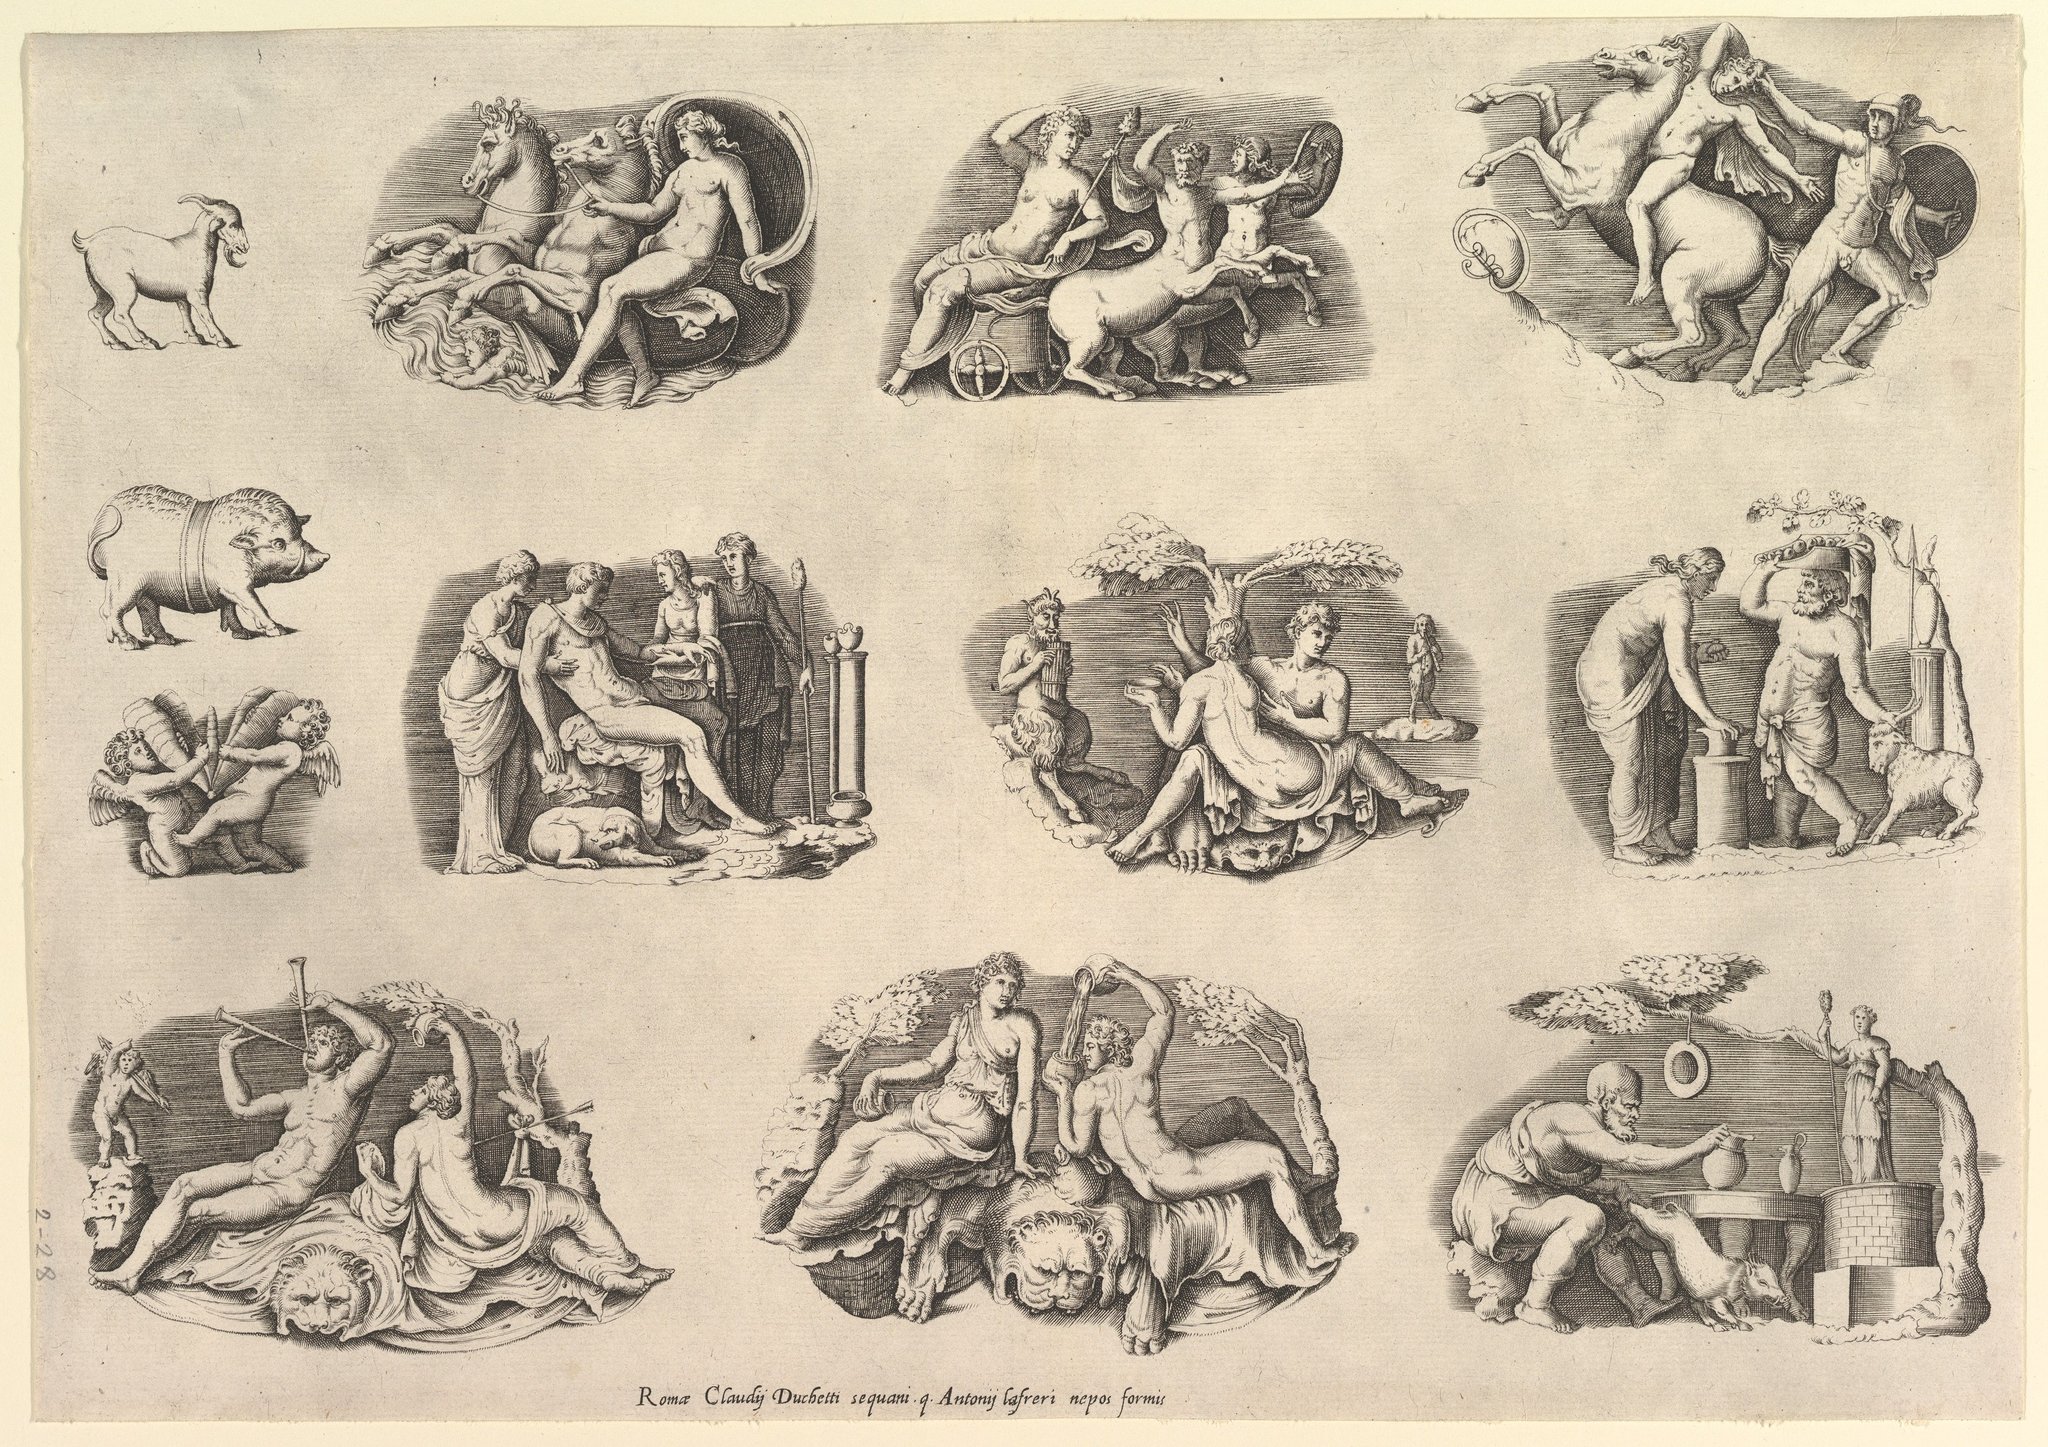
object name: print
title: Subjects after Antique Cameos and Gems, from "Speculum Romanae Magnificentiae"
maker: anonymous, italian, 16th century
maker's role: artist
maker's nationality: italian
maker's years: 1500-1600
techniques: engraving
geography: rome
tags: male nudes,female nudes,centaurs,horses,pigs